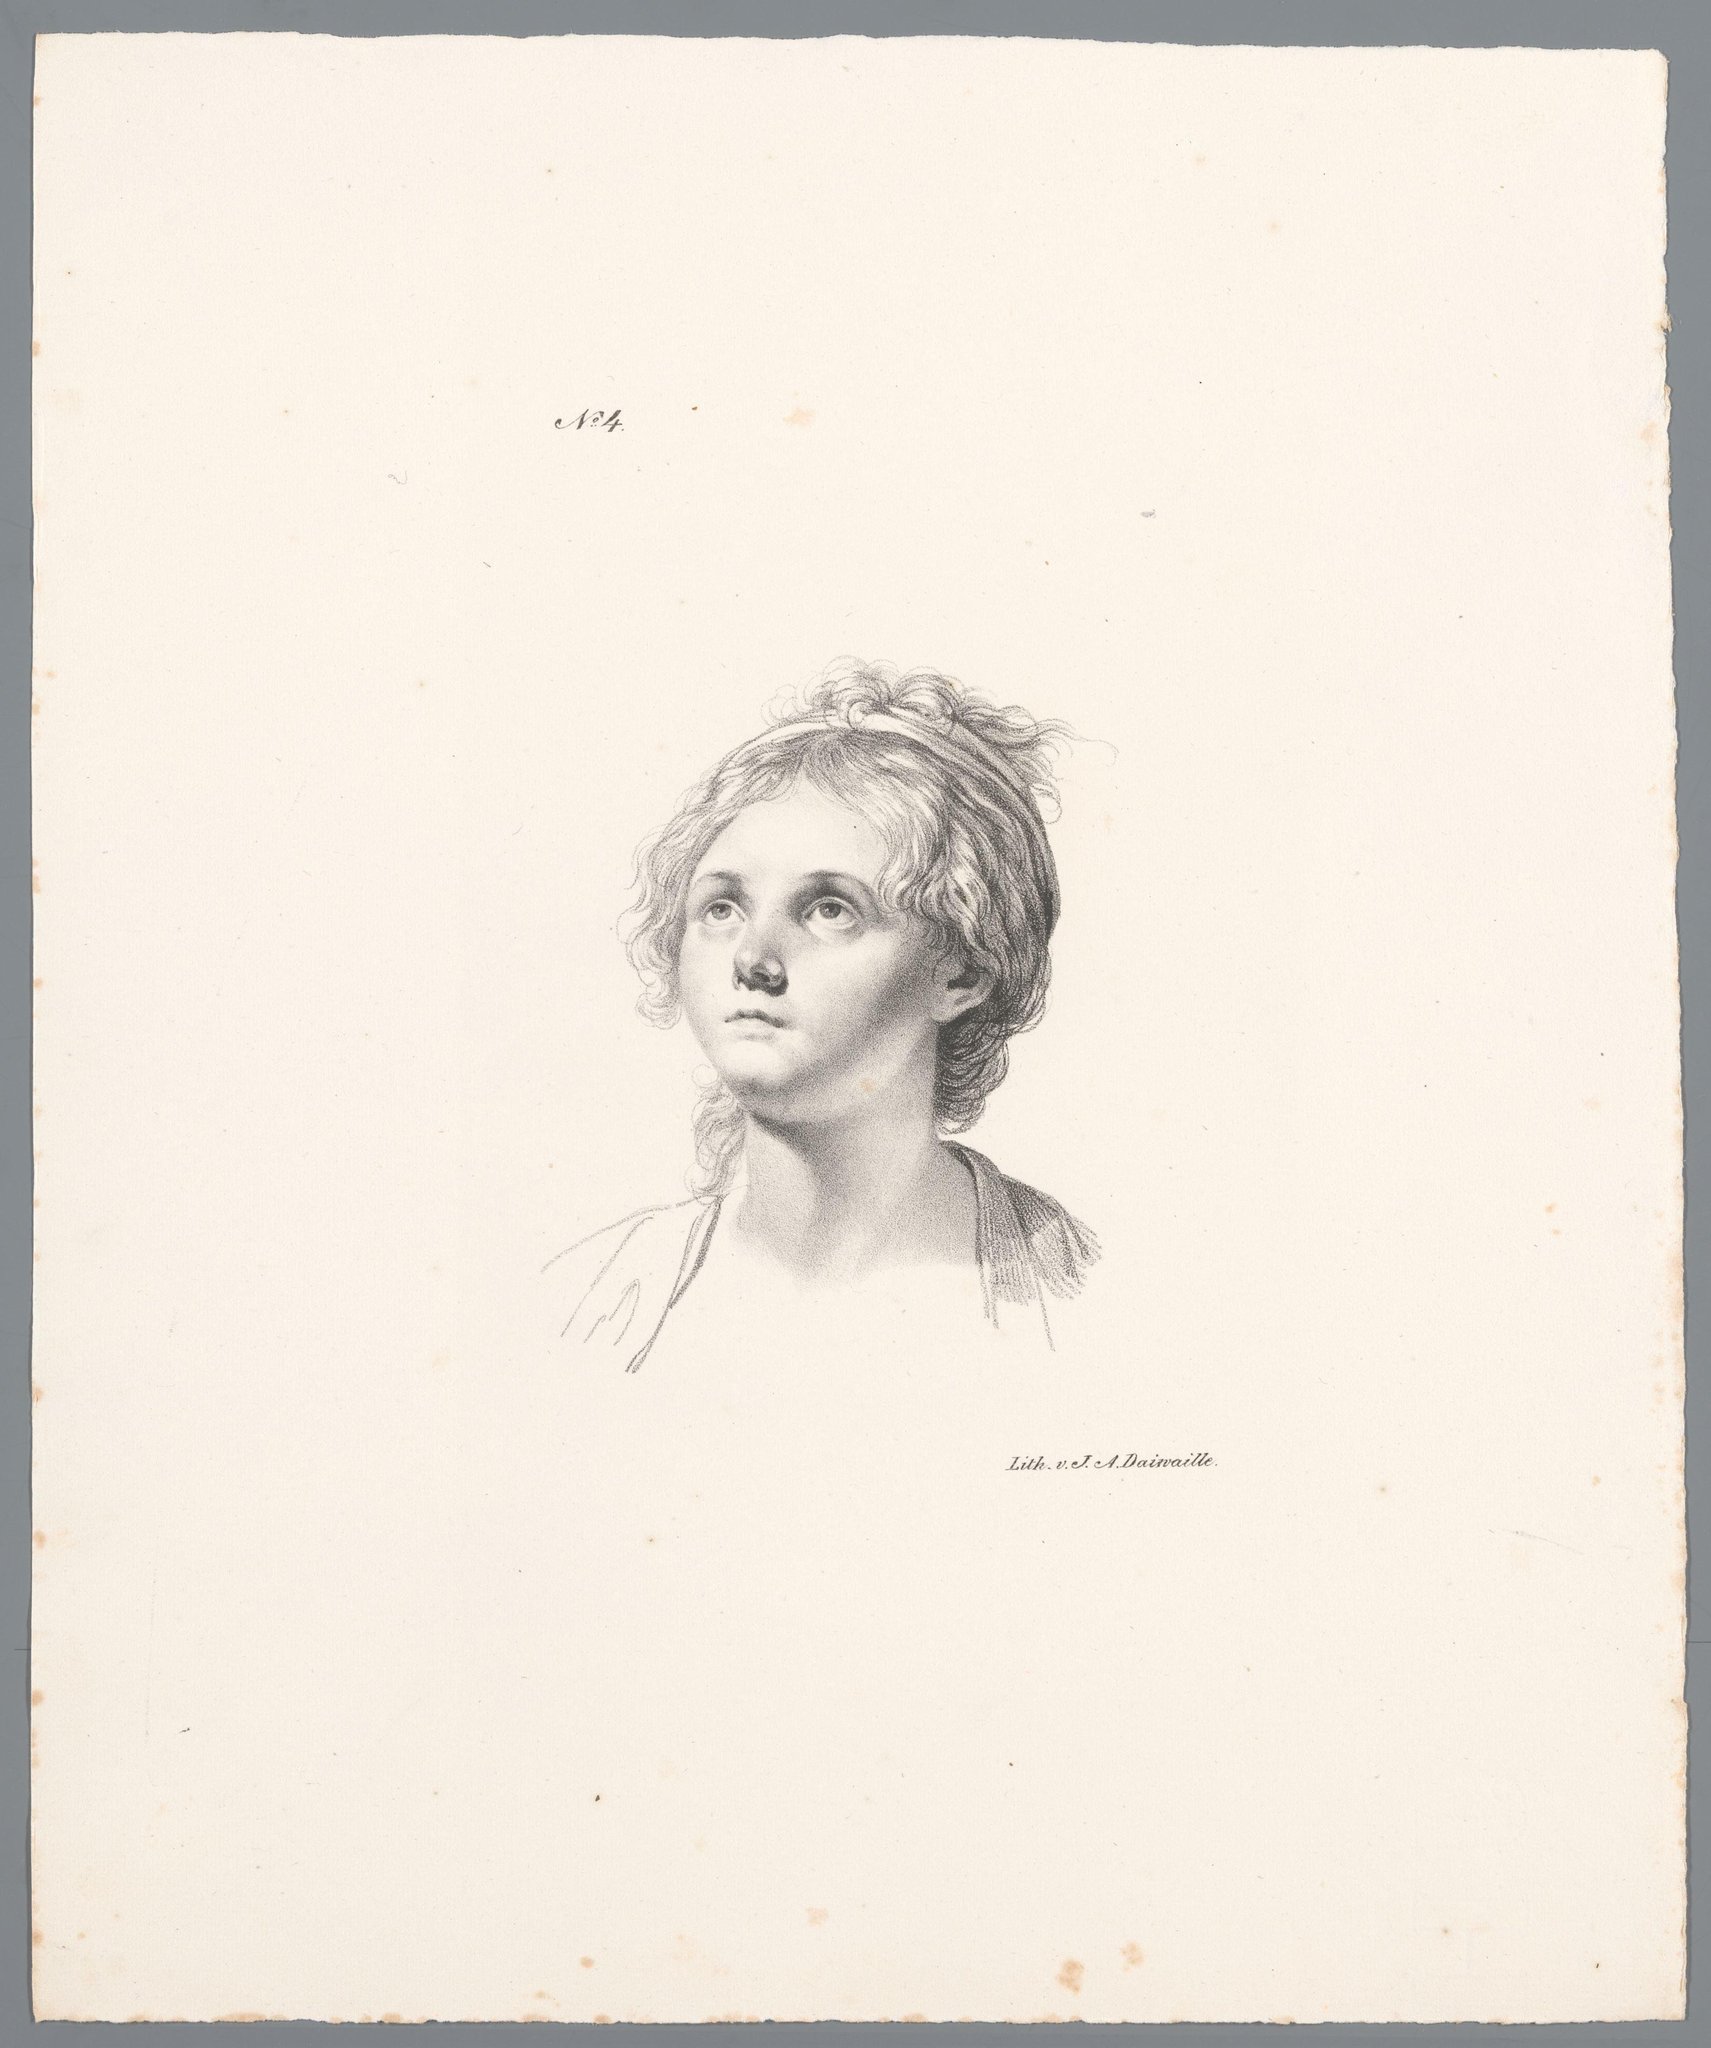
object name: print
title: Hartstochten na J.B. Greuze Nummer Twee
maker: jean augustin daiwaille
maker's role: draughtsman, print maker, printer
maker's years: 1786-1850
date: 1820-1830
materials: paper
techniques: lithograph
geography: amsterdam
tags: adolescent, young woman, maiden, border, ribbon, braid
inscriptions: collector's mark: Lugt 2228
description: 'Hartstochten na J.B. Greuze' bestaat uit twee of drie genummerde reeksen. (Sommige nummers komen drie keer voor op drie verschillende afbeeldingen.) Binnen deze omslag bevinden zich achttien verschillende afbeeldingen. Mogelijk heeft dit te maken met de twee momenten waarop Daiwaille de reeks uitgaf, ten tijden van zijn directeurschap aan de Rijksakademie in Amsterdam en daarna als zelfstandige. De omslag behoort waarschijnlijk bij een van deze twee series. Zie Marres-Schretlen in het Bulletin van het Rijksmuseum.